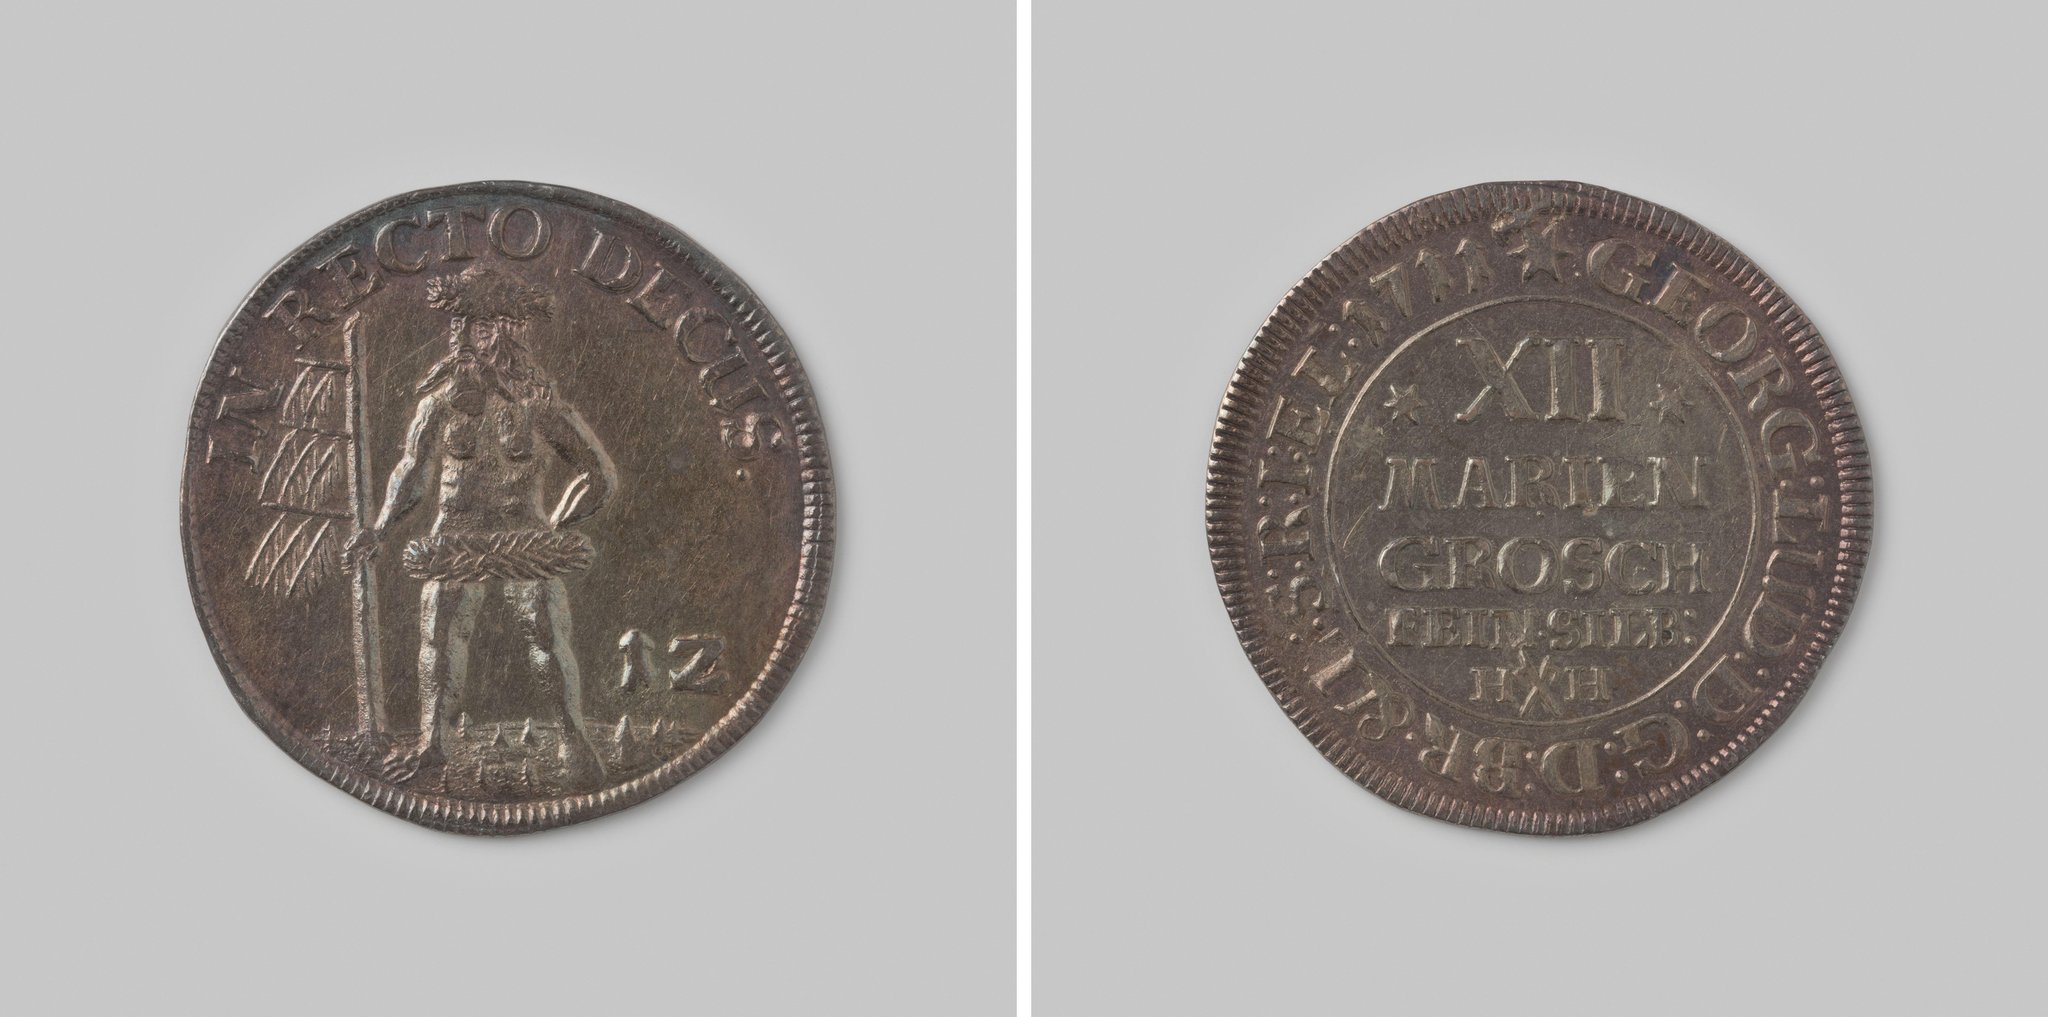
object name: twaalf mariëngroschen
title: Brunswijk-Luneburg-Calenberg-Hannover, Georg I ludwig, 12 mariëngroschen, 1711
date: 1711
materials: silver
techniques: striking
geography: clausthal-zellerfeld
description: Zilveren munt. Voorzijde: in landschap staande wildeman, met rechterhand denneboom vasthoudend. Cijfer 12 in het veld. Keerzijde: waarde-aanduiding in vier regels. Jaartal aan het eind van het omschrift. Gladde rand.